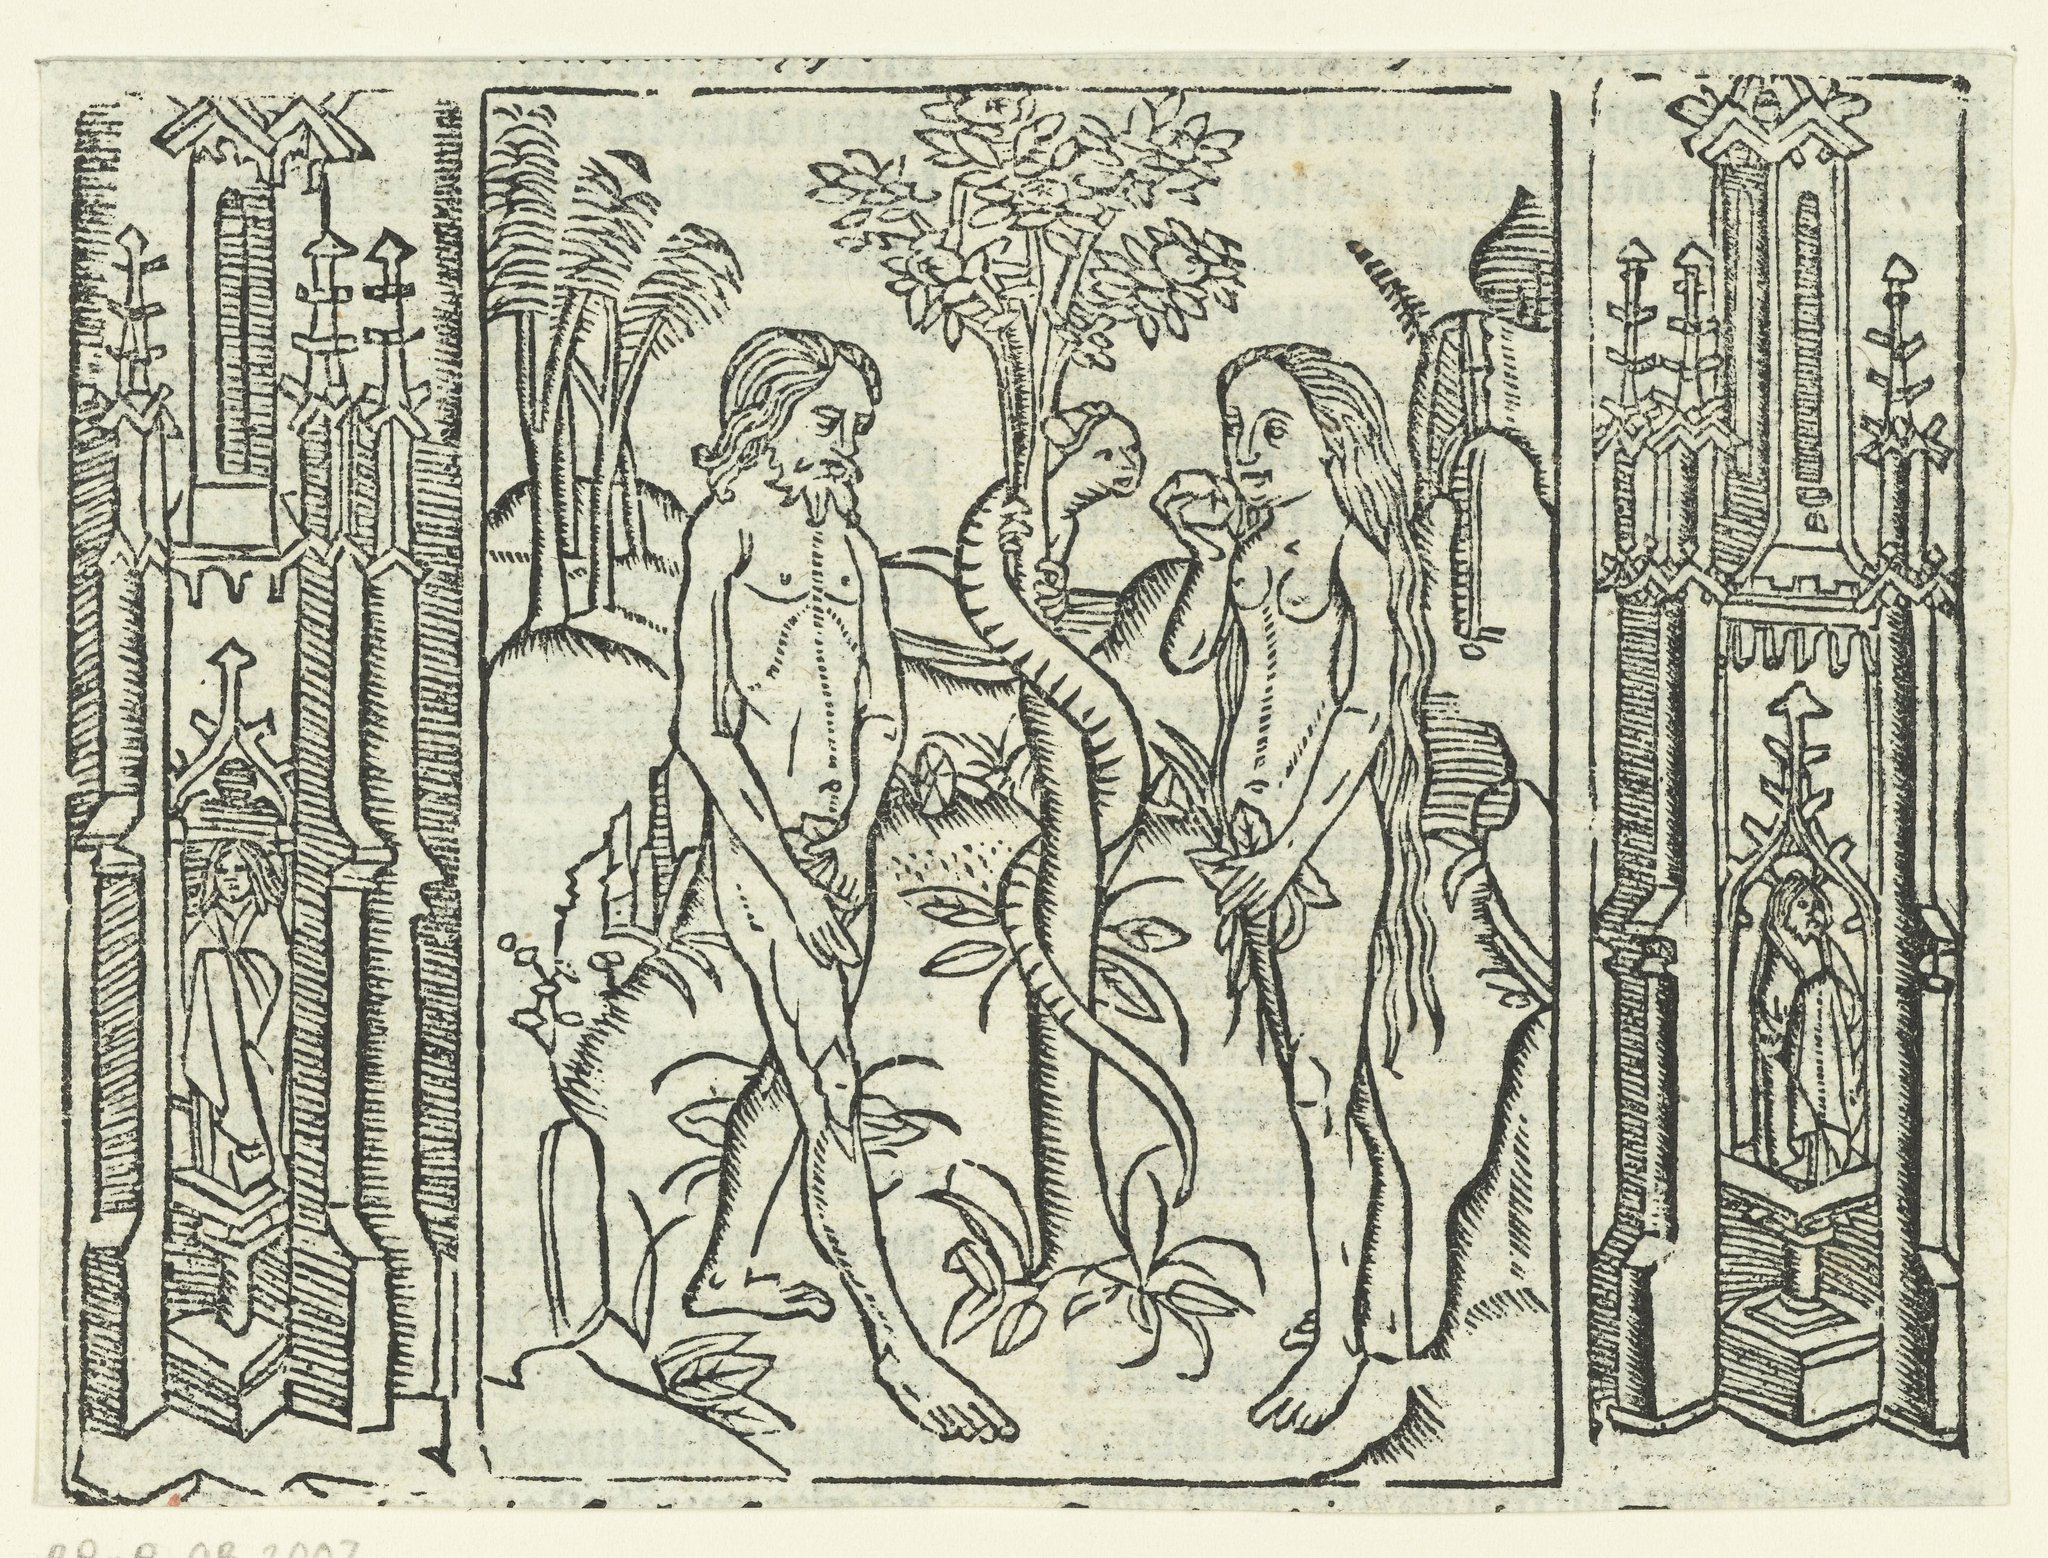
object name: print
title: De zondeval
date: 1480-1500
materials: paper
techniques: woodcut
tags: temptation and fall (scenes with both adam and eve)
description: Eén blad van 113 uit Ludolphus de Saxonia, "Dit es dleué ons liefs heeren ihesu christi". Anonieme Nederlandse vertaling. Uitgegeven door Henrick Eckert van Homberch te Antwerpen in 1503. Botke, K. Deze 113 houtsneden, die meestal reeds in vroege Nederlandse boeken gebruikt zijn, worden toegeschreven aan de tweede Meester van Delft, de Meester van de Delbecq-Schreiber-passie en de Meester van de Virgo inter Virgines. In Conway (1884) en in "De gulden passer"(1951) zijn ook eerdere versies opgenomen. Botke, K.